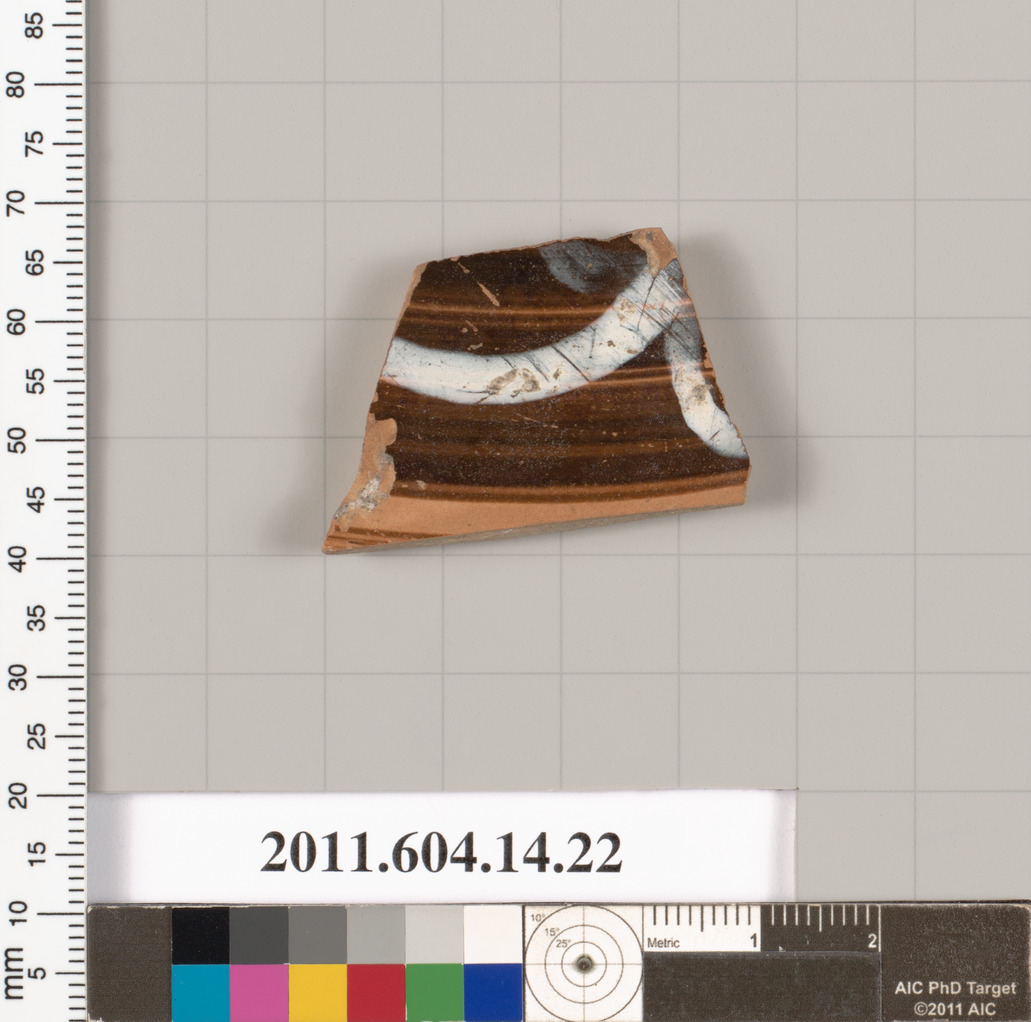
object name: undetermined closed shape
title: Terracotta fragment of an undetermined closed shape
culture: unknown fabric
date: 600-501 BCE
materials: terracotta